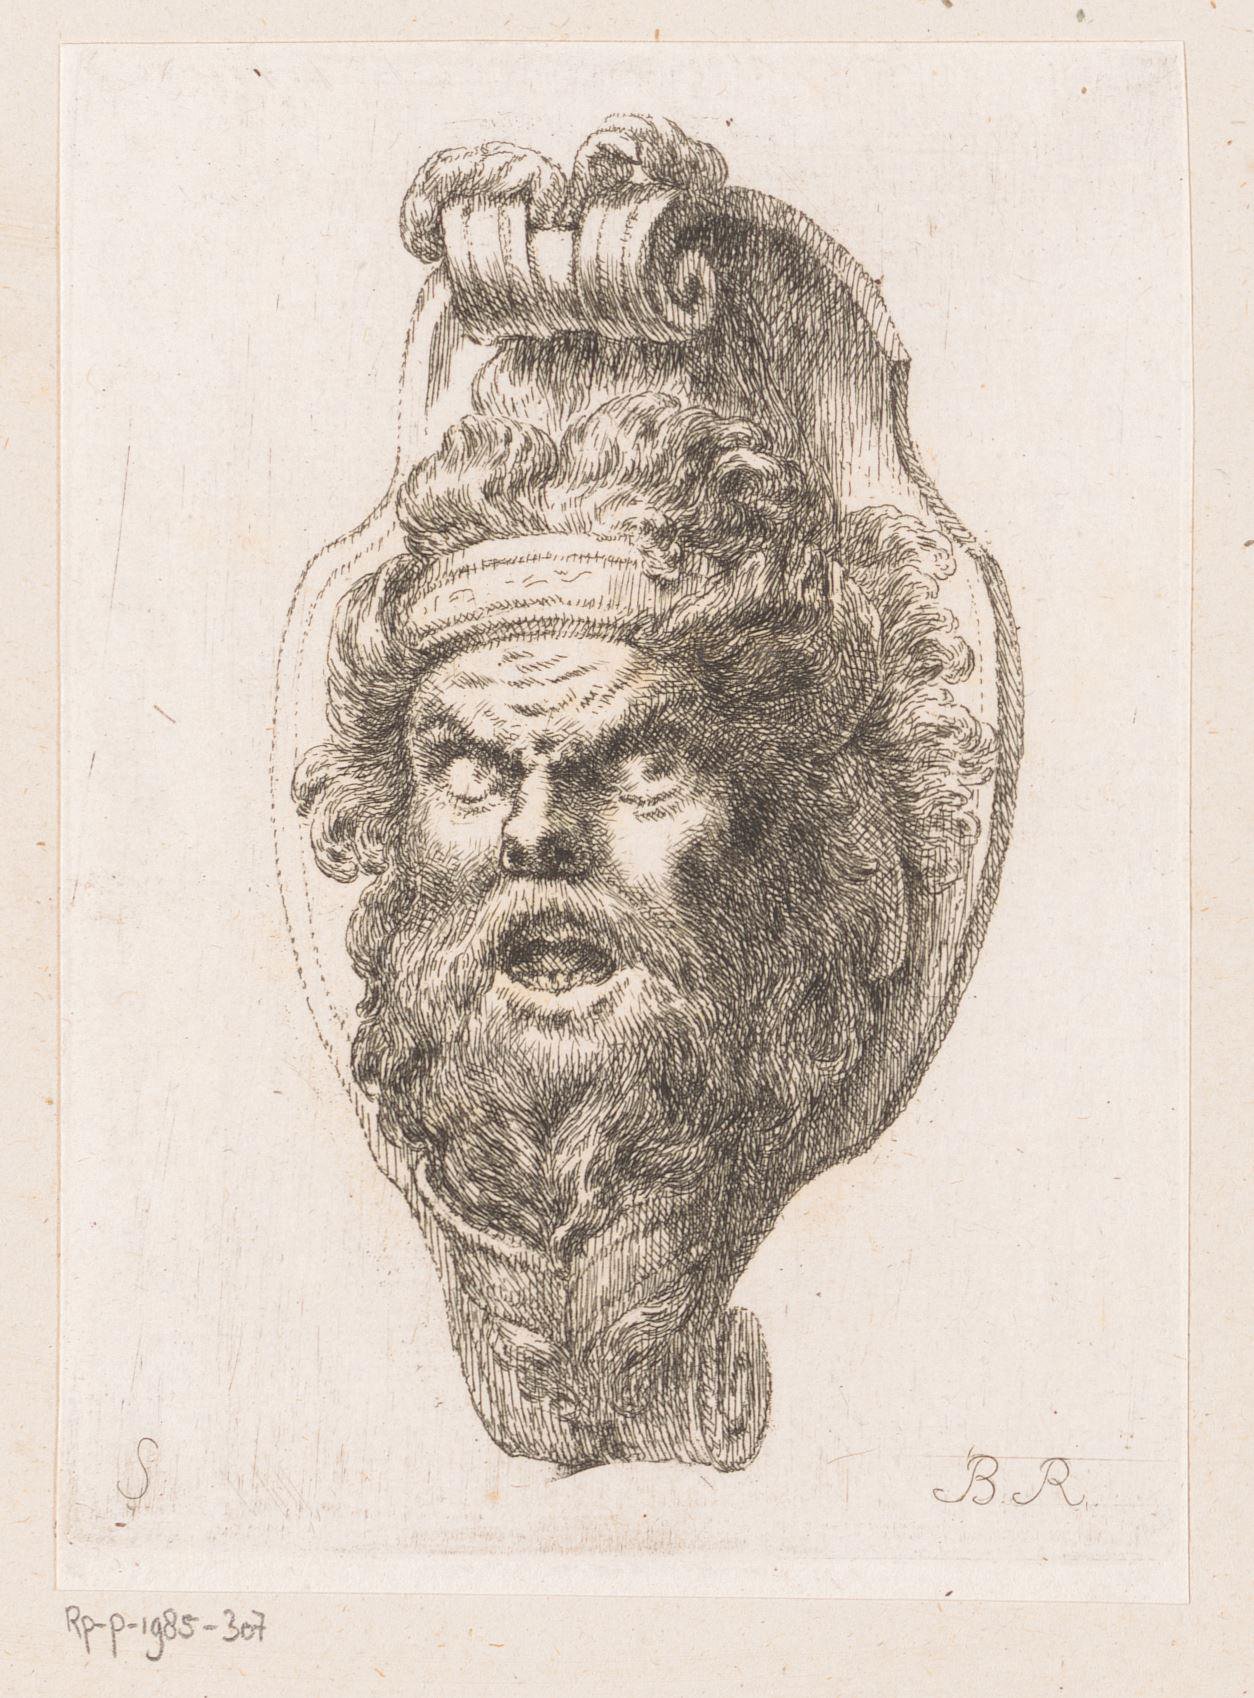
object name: print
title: Mascaron met mannenkop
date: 1759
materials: paper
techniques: etching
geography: berlin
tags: mask, mascaron ~ ornament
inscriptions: collector's mark: Lugt 2228, collector's mark: Lugt 2760